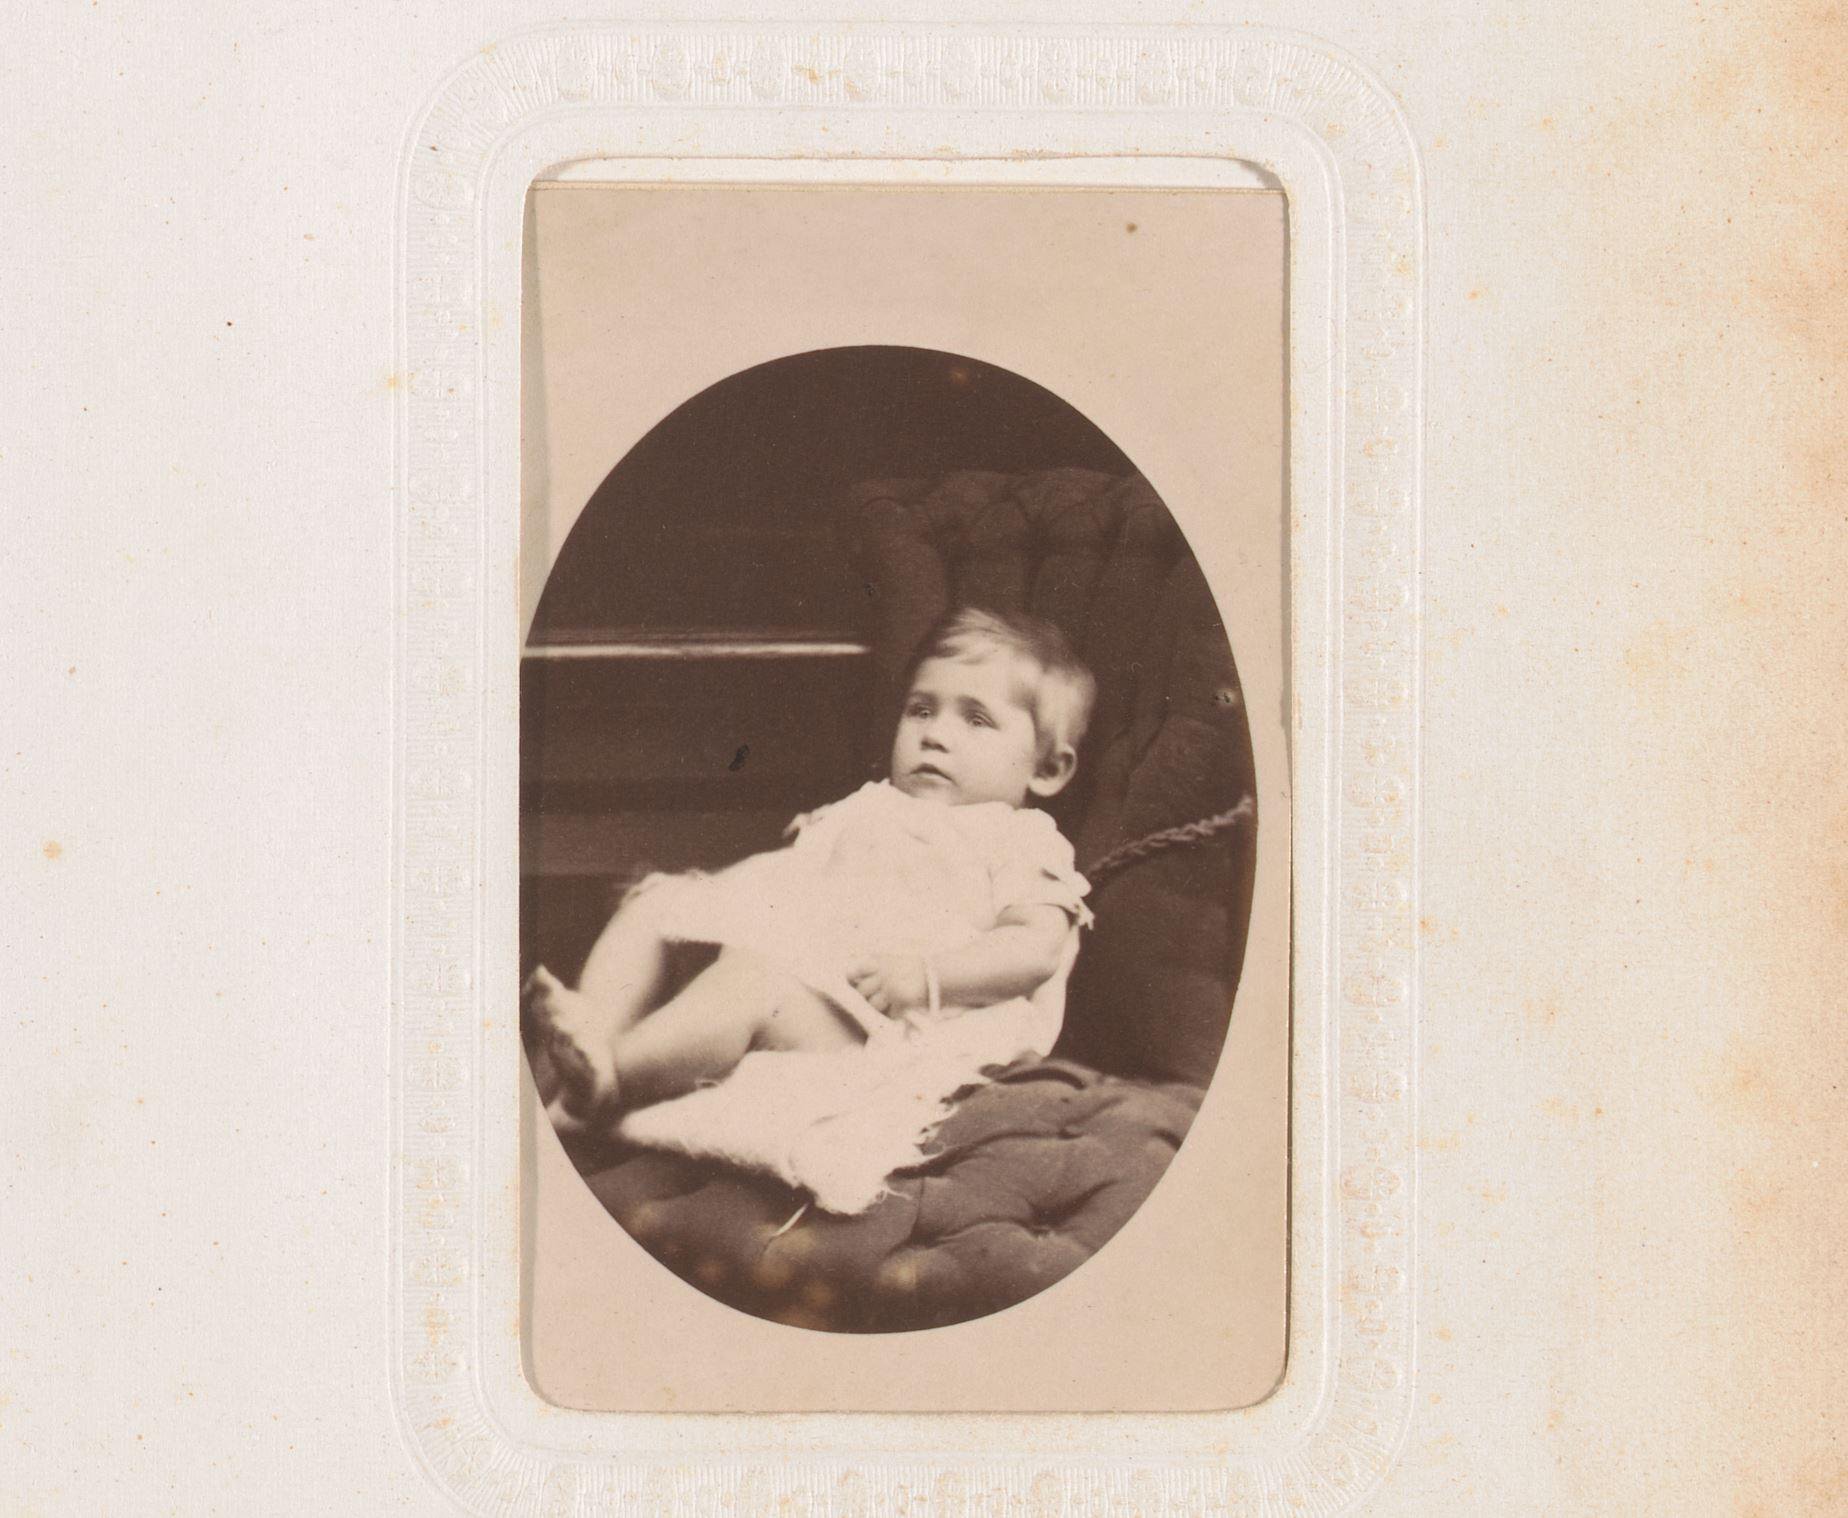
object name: semi enamel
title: Portret van een achteroverleunend kind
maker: Anonymous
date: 1860-1900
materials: cardboard, celluloid, photographic support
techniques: albumen print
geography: netherlands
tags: leaning backward, historical persons, tot, toddler ~ the ages of man